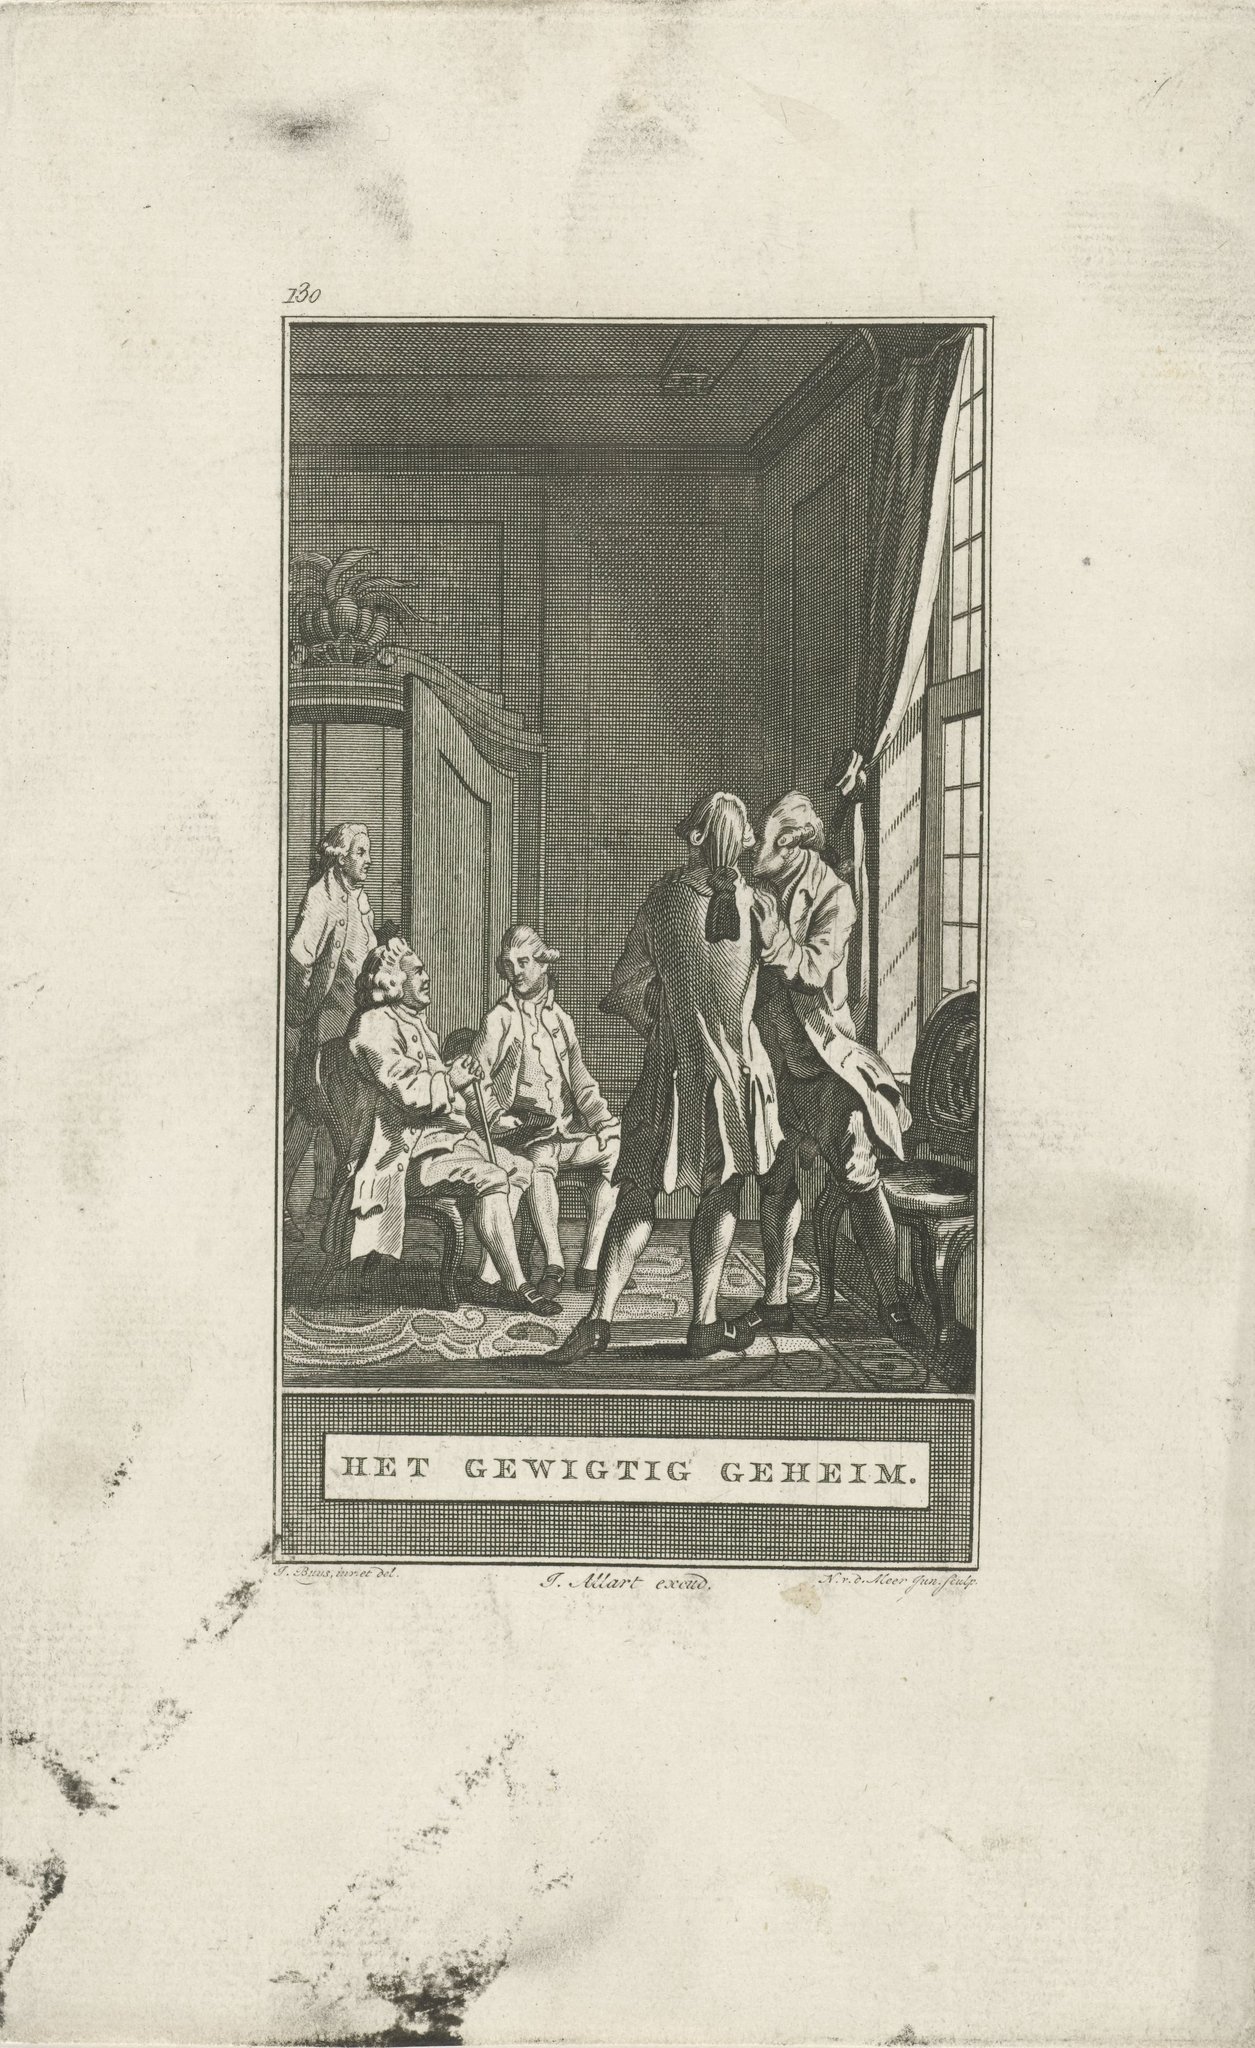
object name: print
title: Het gewigtig geheim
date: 1778-1785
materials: paper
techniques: etching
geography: amsterdam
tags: secrecy, latency, concealment; 'secretezza' (ripa), living-room, parlour, sitting-room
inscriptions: collector's mark: Lugt 2228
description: Prent bij: Gellert, Christian Fürchtegott. Fabelen en vertelsels. 3 dln. Amsterdam: Pieter Meyer, 1772-1774. De prenten bij deze publicatie werden later uitgegeven. De exemplaren uitgegeven door de weduwe Jacobus Loveringh & Johannes Allart tussen 1777 en 1778, de exemplaren uitgegeven door alleen Johannes Allart tussen 1778 en 1785.